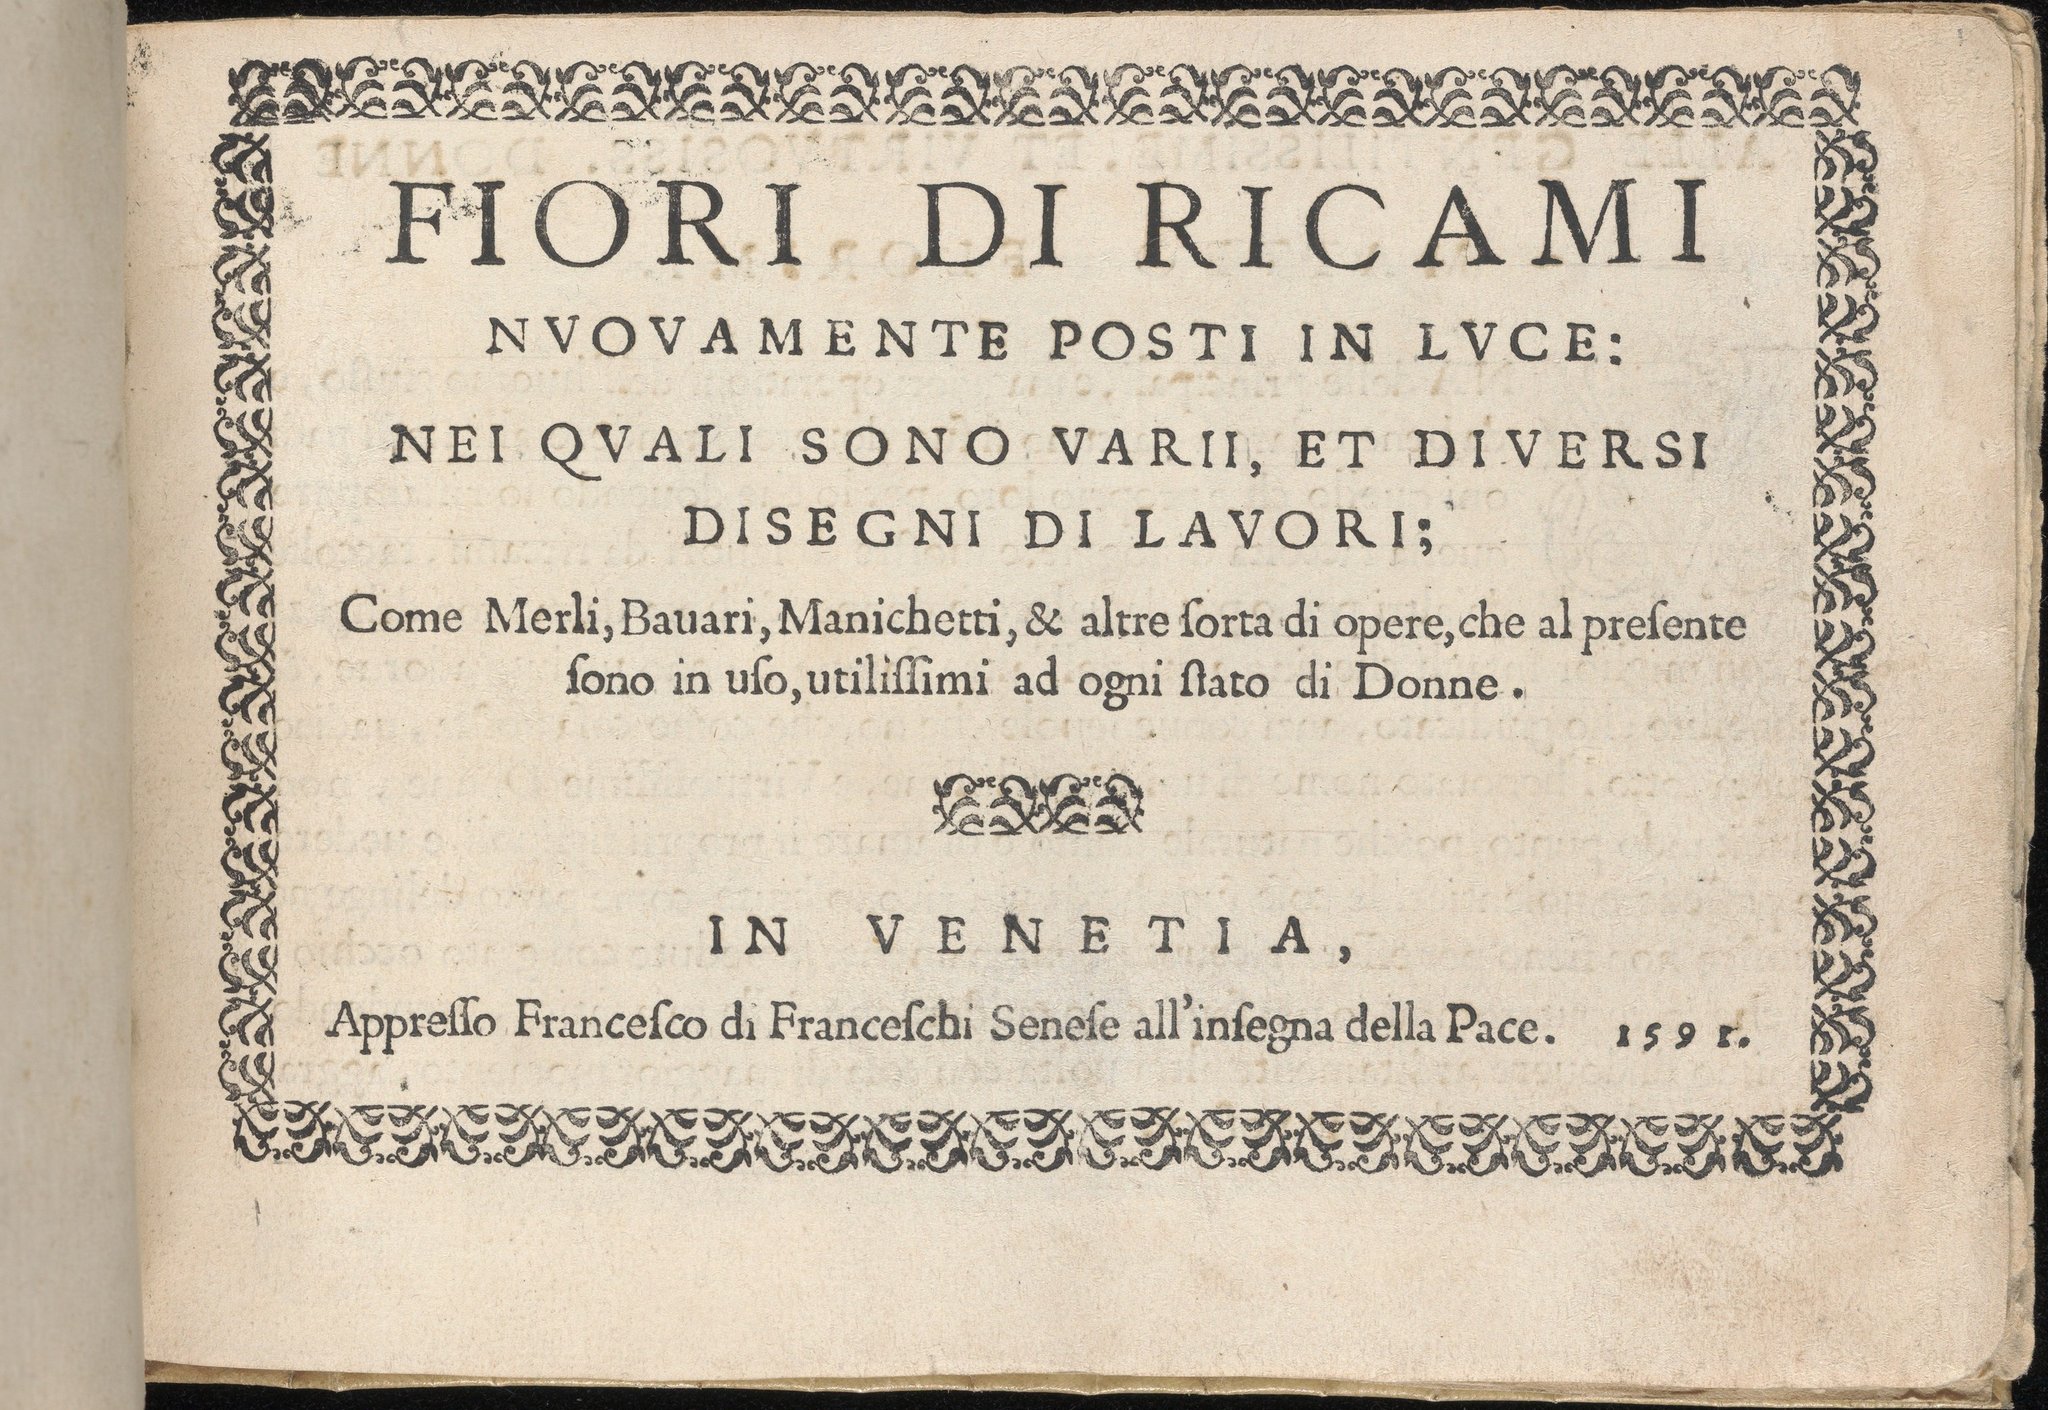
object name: book print ornament archiecture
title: Fiori di Ricami Nuovamente Posti in Luce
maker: matteo florimi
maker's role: designer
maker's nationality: italian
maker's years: 1581-1613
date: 1591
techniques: woodcut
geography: italy